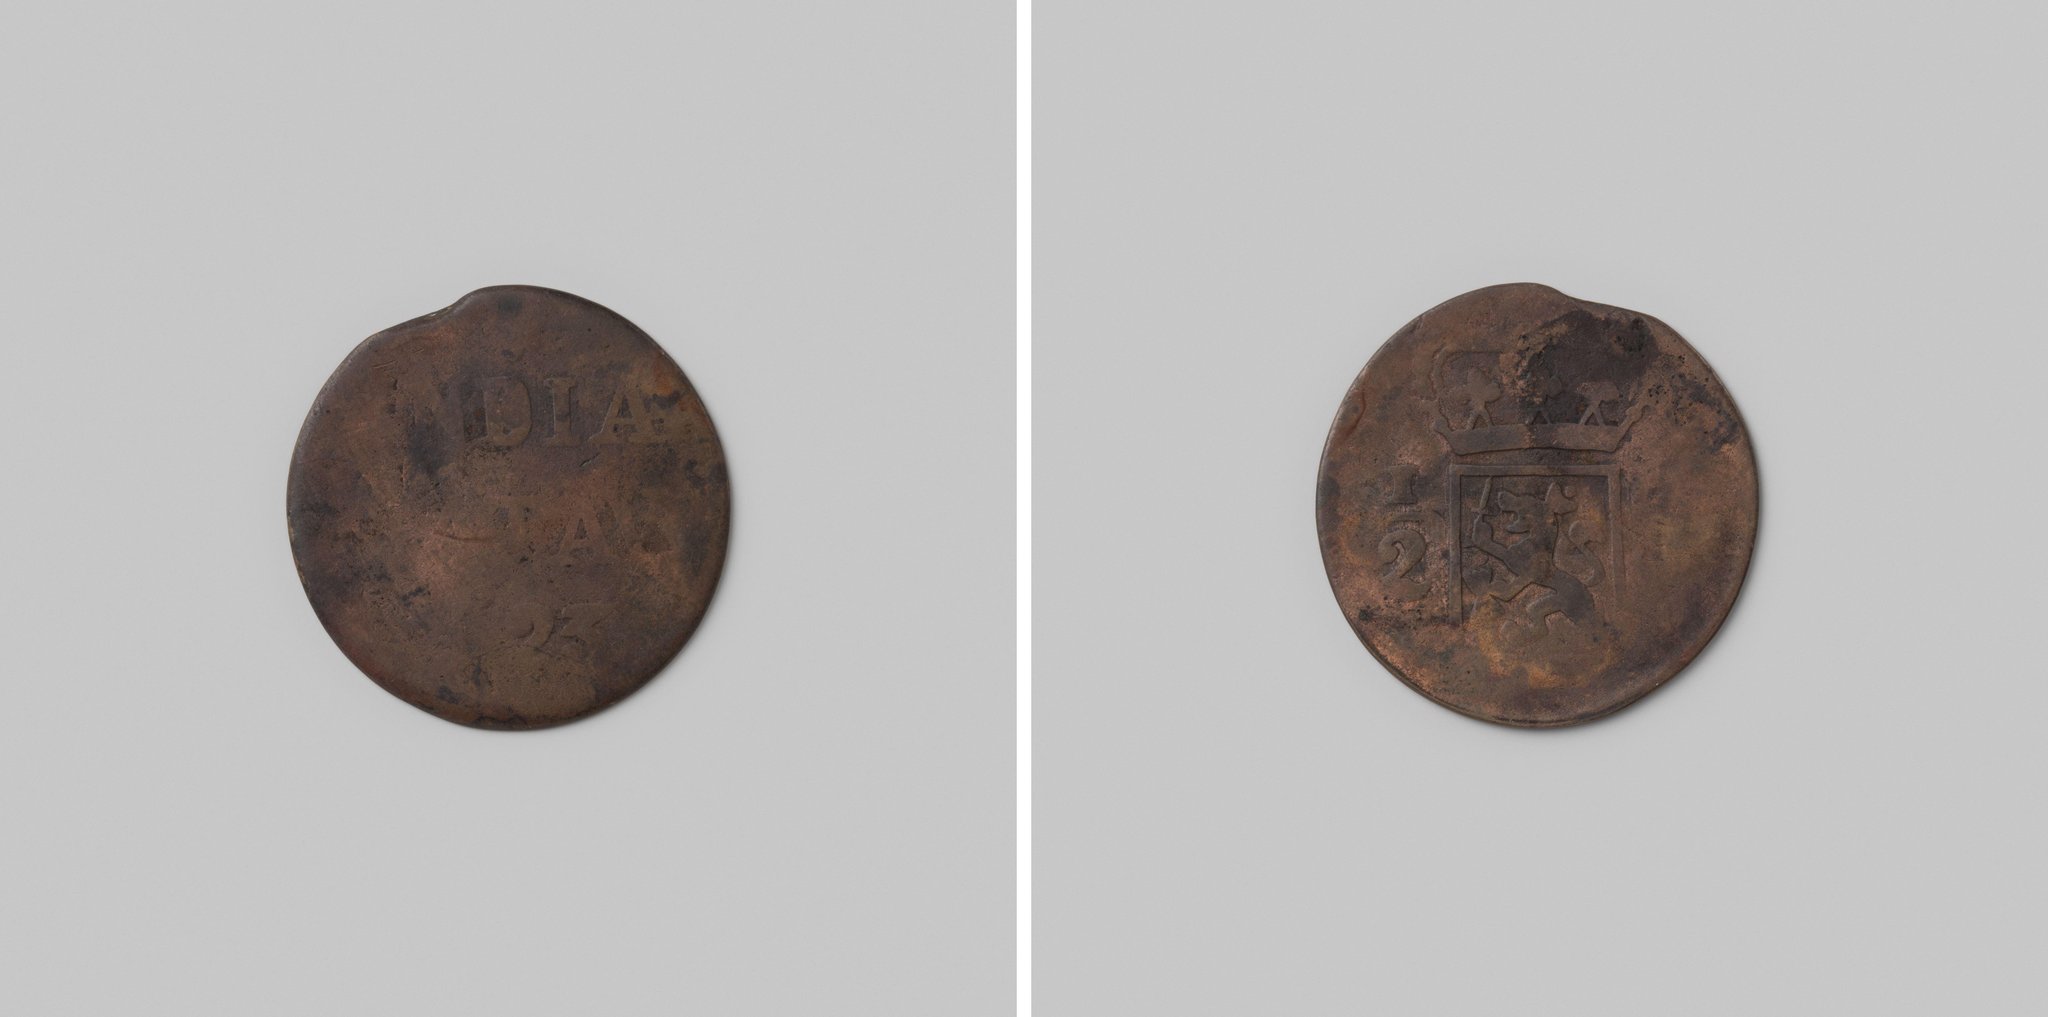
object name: coin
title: Munt van twee cent van de VOC uit 1823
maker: Anonymous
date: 1823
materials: copper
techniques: striking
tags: dutch east indies, the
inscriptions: inscription: ‘2’, inscription: ‘...NDIA / ..ATAV’, inscription: ‘Jacques Schulman / Numismaat / Keizersgracht 448 / Amsterdam-C.’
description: Koperen 2 cent VOC-muntje uit Nederlands-Indië uit1823. Voorzijde: opschrift. Keerzijde: wapen met leeuw erin, slecht te lezen / zien. Het muntje zit in een vierkant envelopje met opschrift.